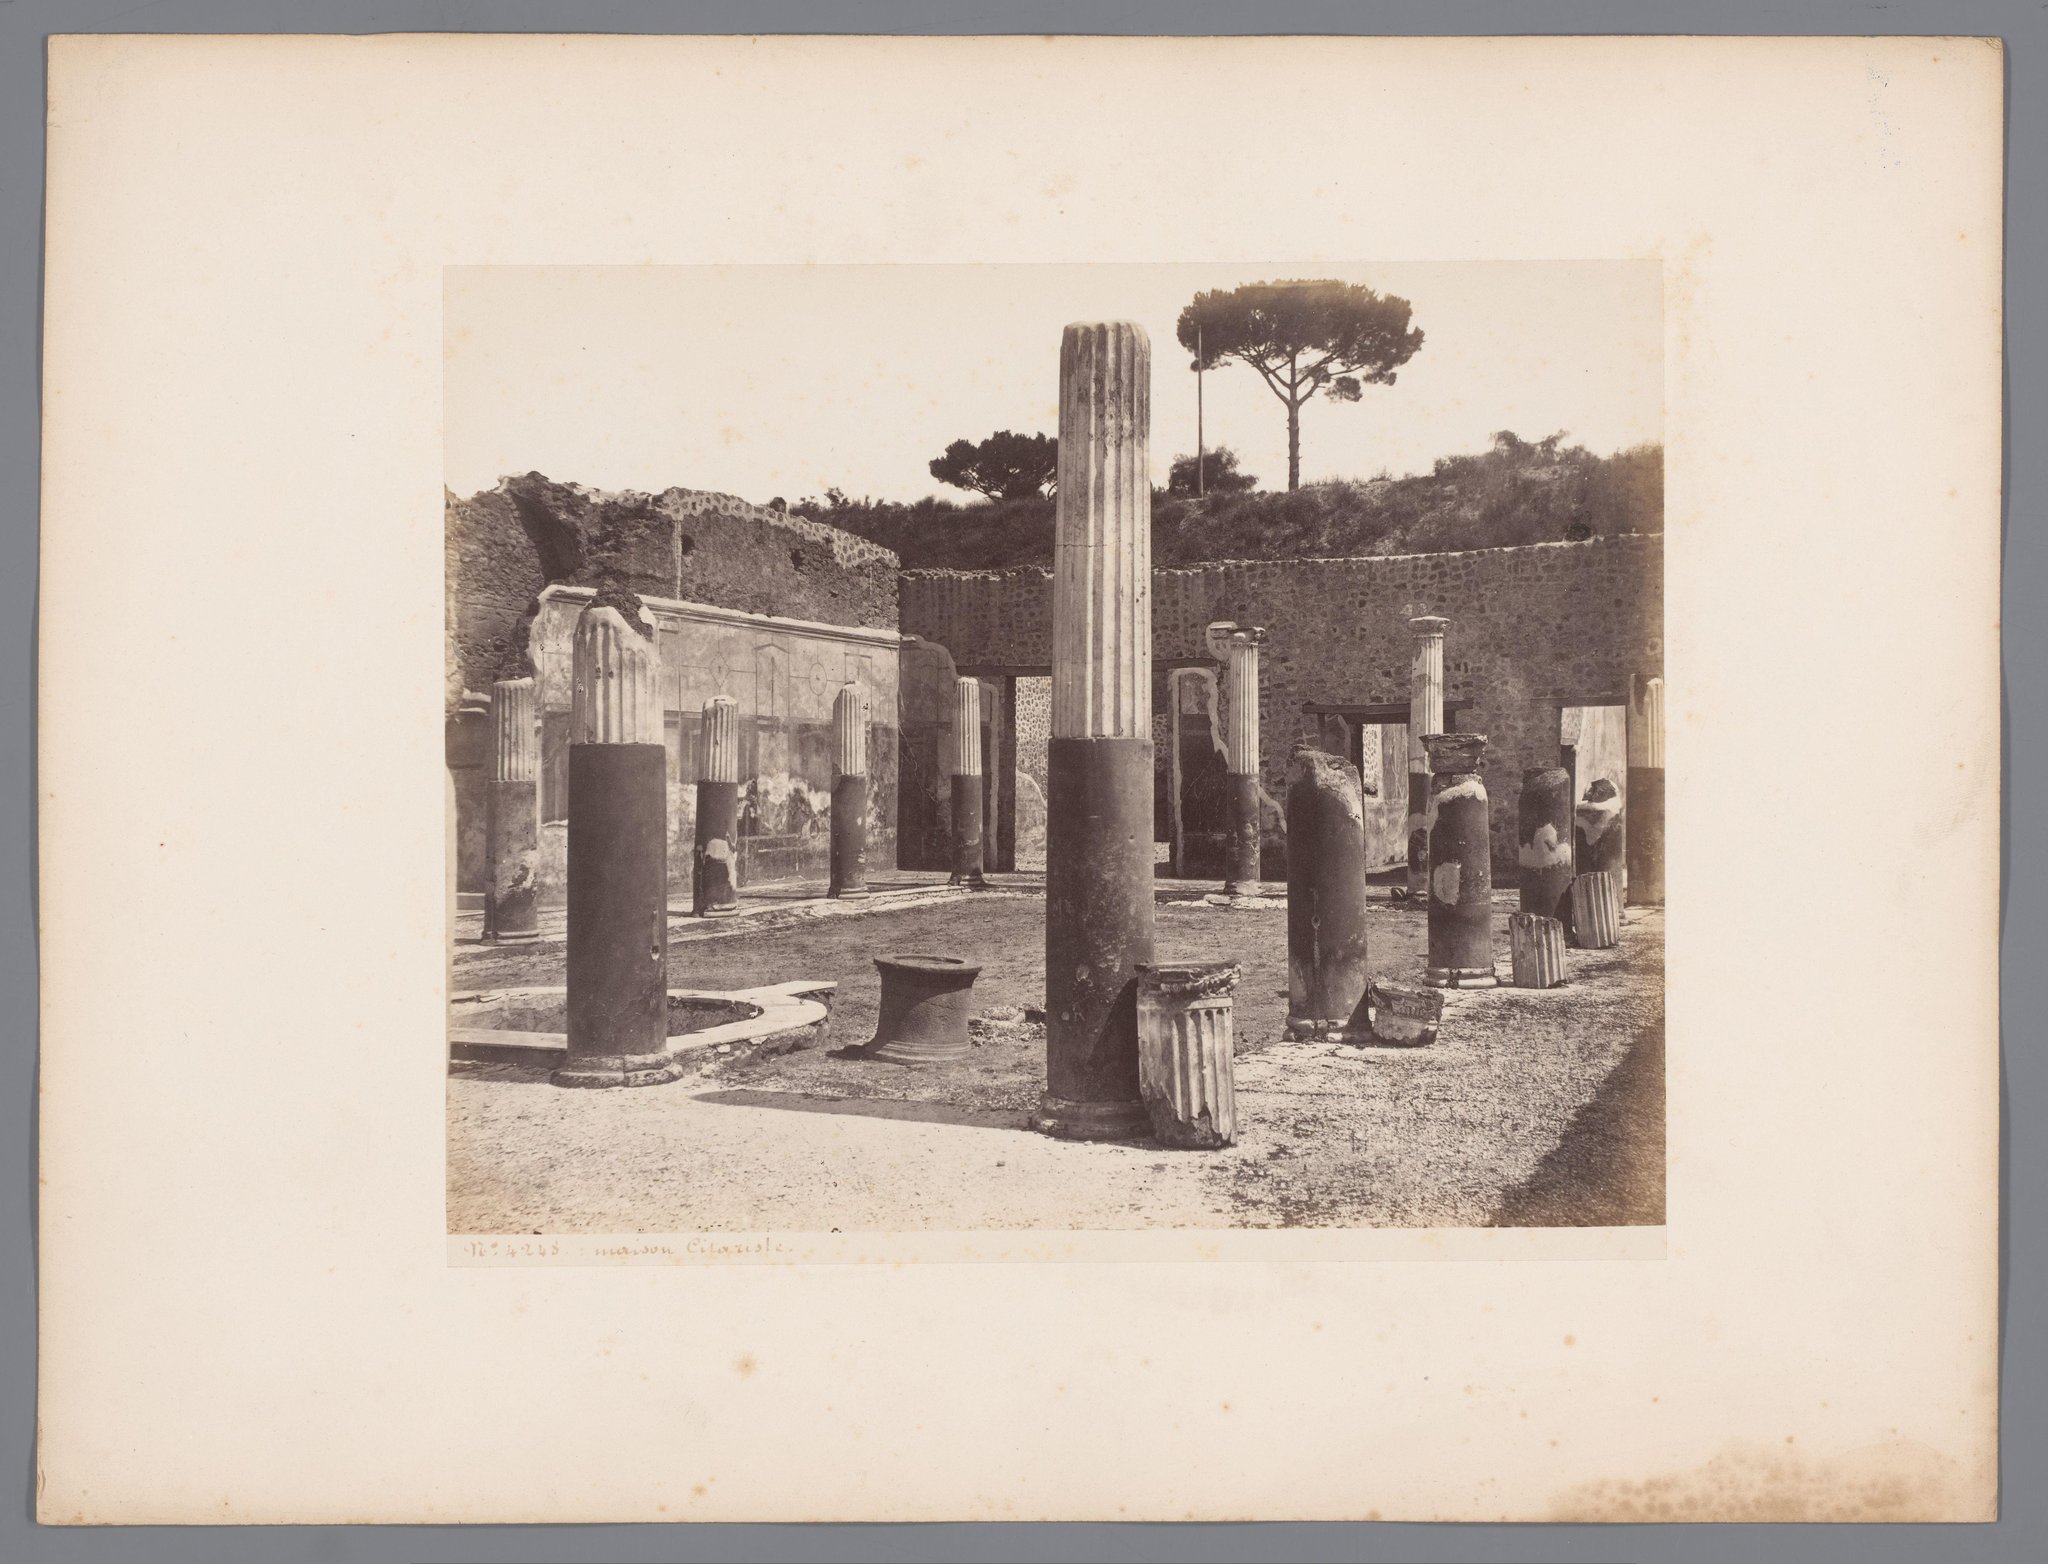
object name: photograph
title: Gezicht op de ruïnes van Maison Citariste te Pompeï, Italië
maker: giorgio sommer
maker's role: fotograaf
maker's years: 1834-1914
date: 1857-1875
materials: cardboard, paper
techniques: albumen print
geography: pompeii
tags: excavation ~ archaeology, ruin of a dwelling, house, castle, etc., pompeii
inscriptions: number: ‘58’, number: ‘No. 4248’, number: ‘21’, number: ‘11’